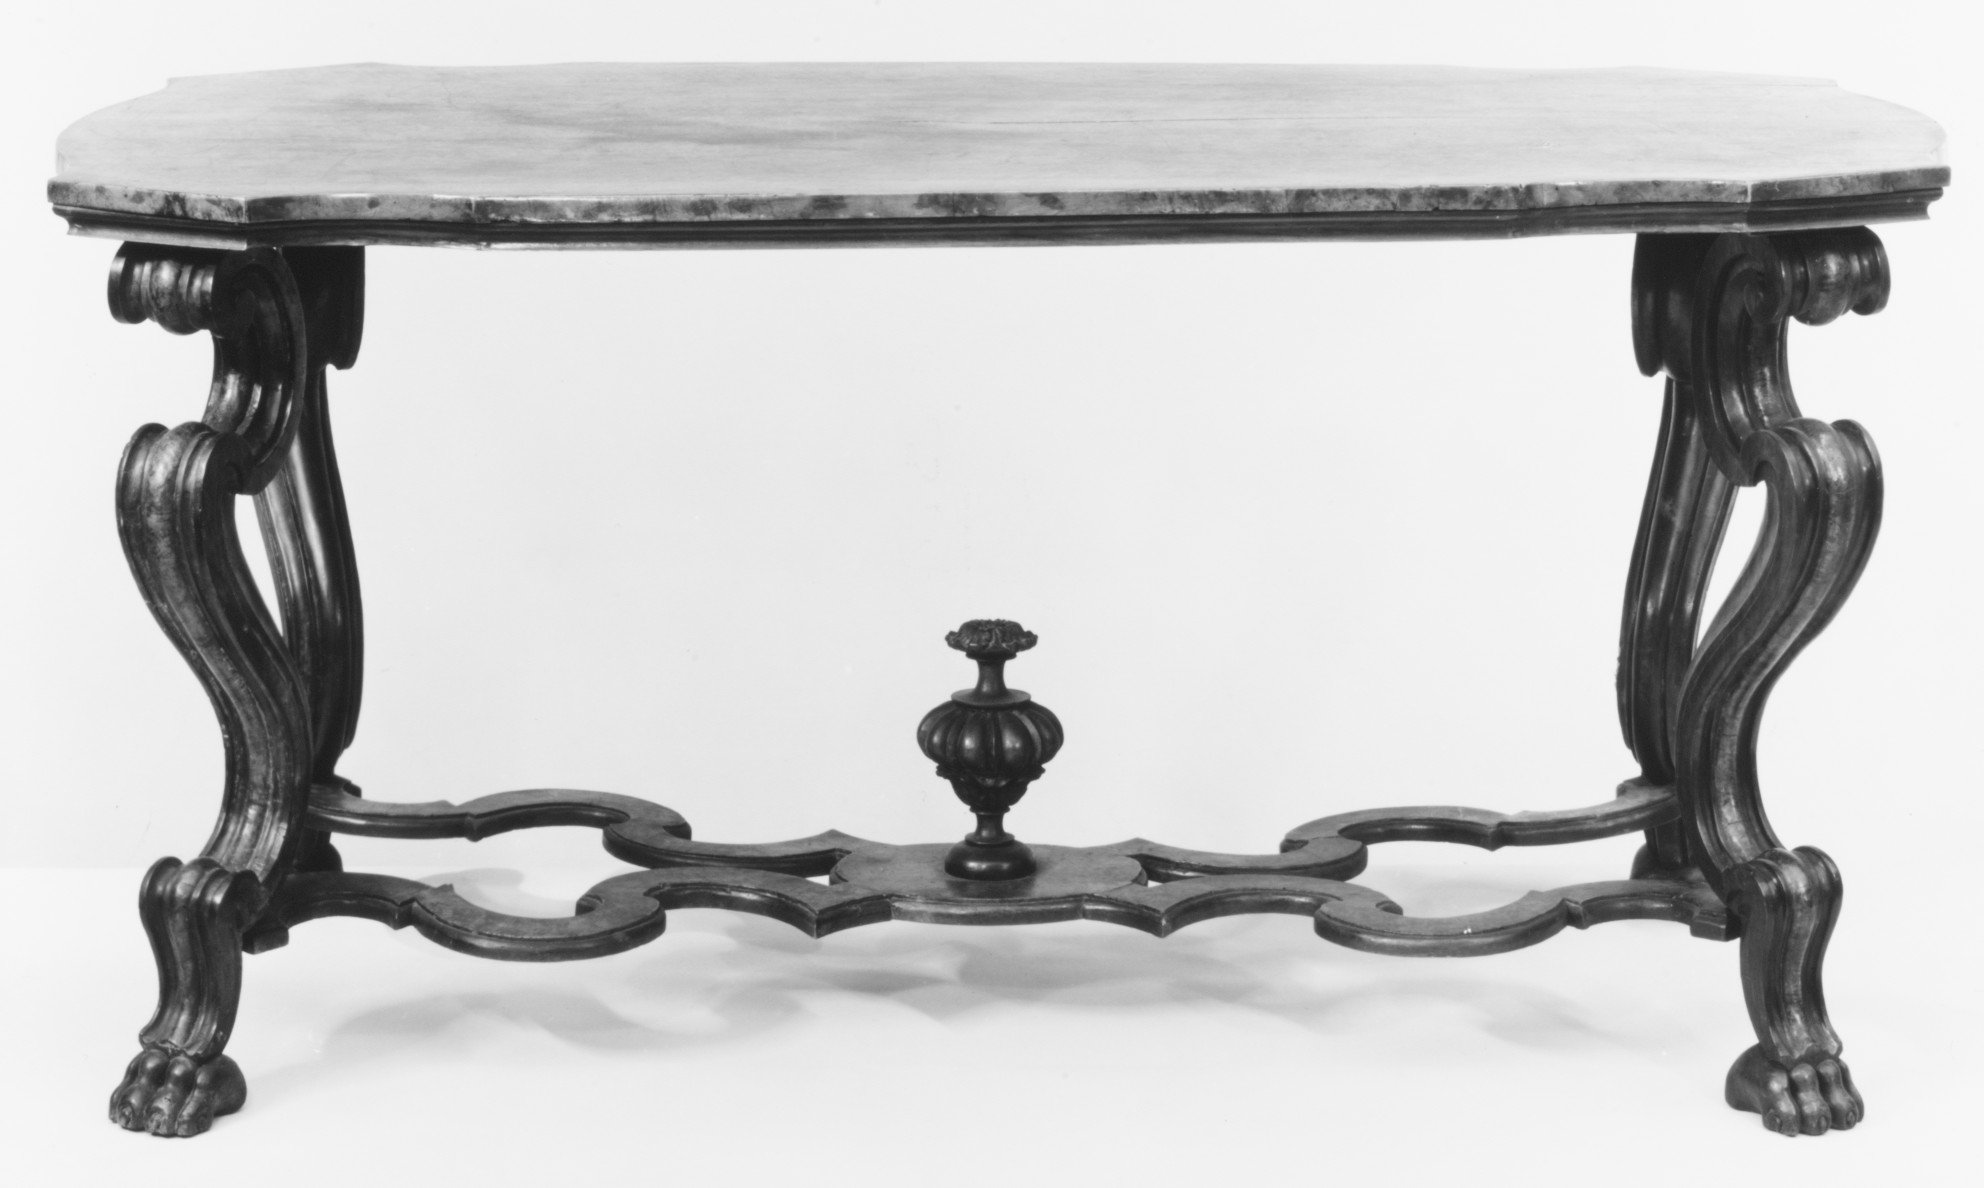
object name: center table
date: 1701-1733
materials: wood